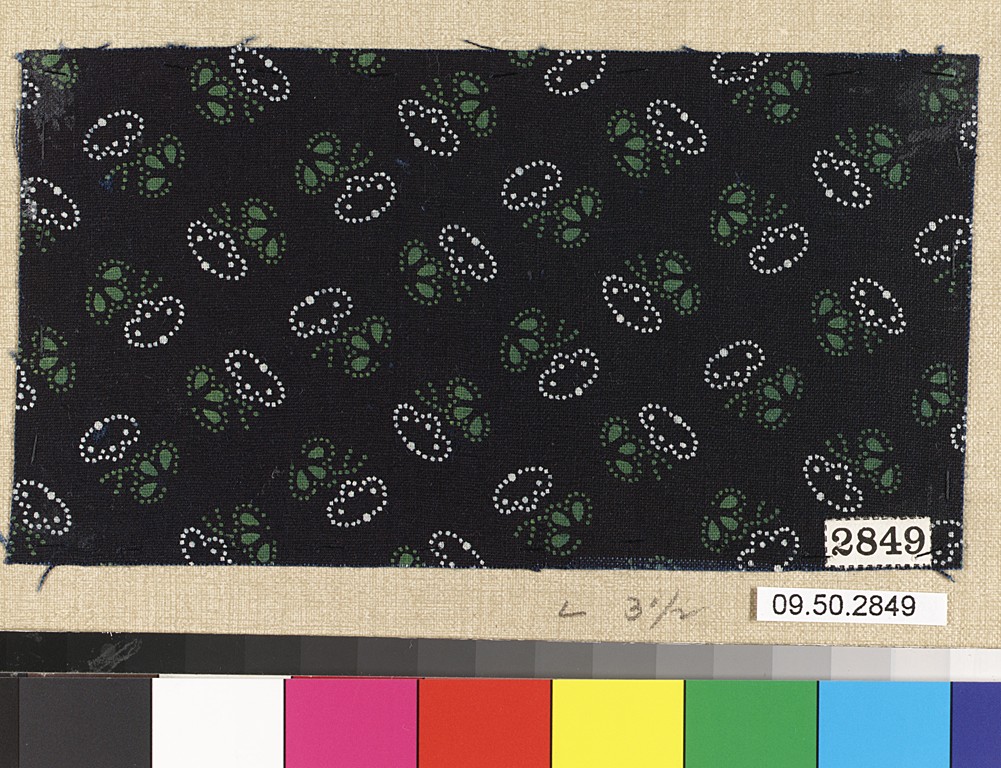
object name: piece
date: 1801-1900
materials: cotton